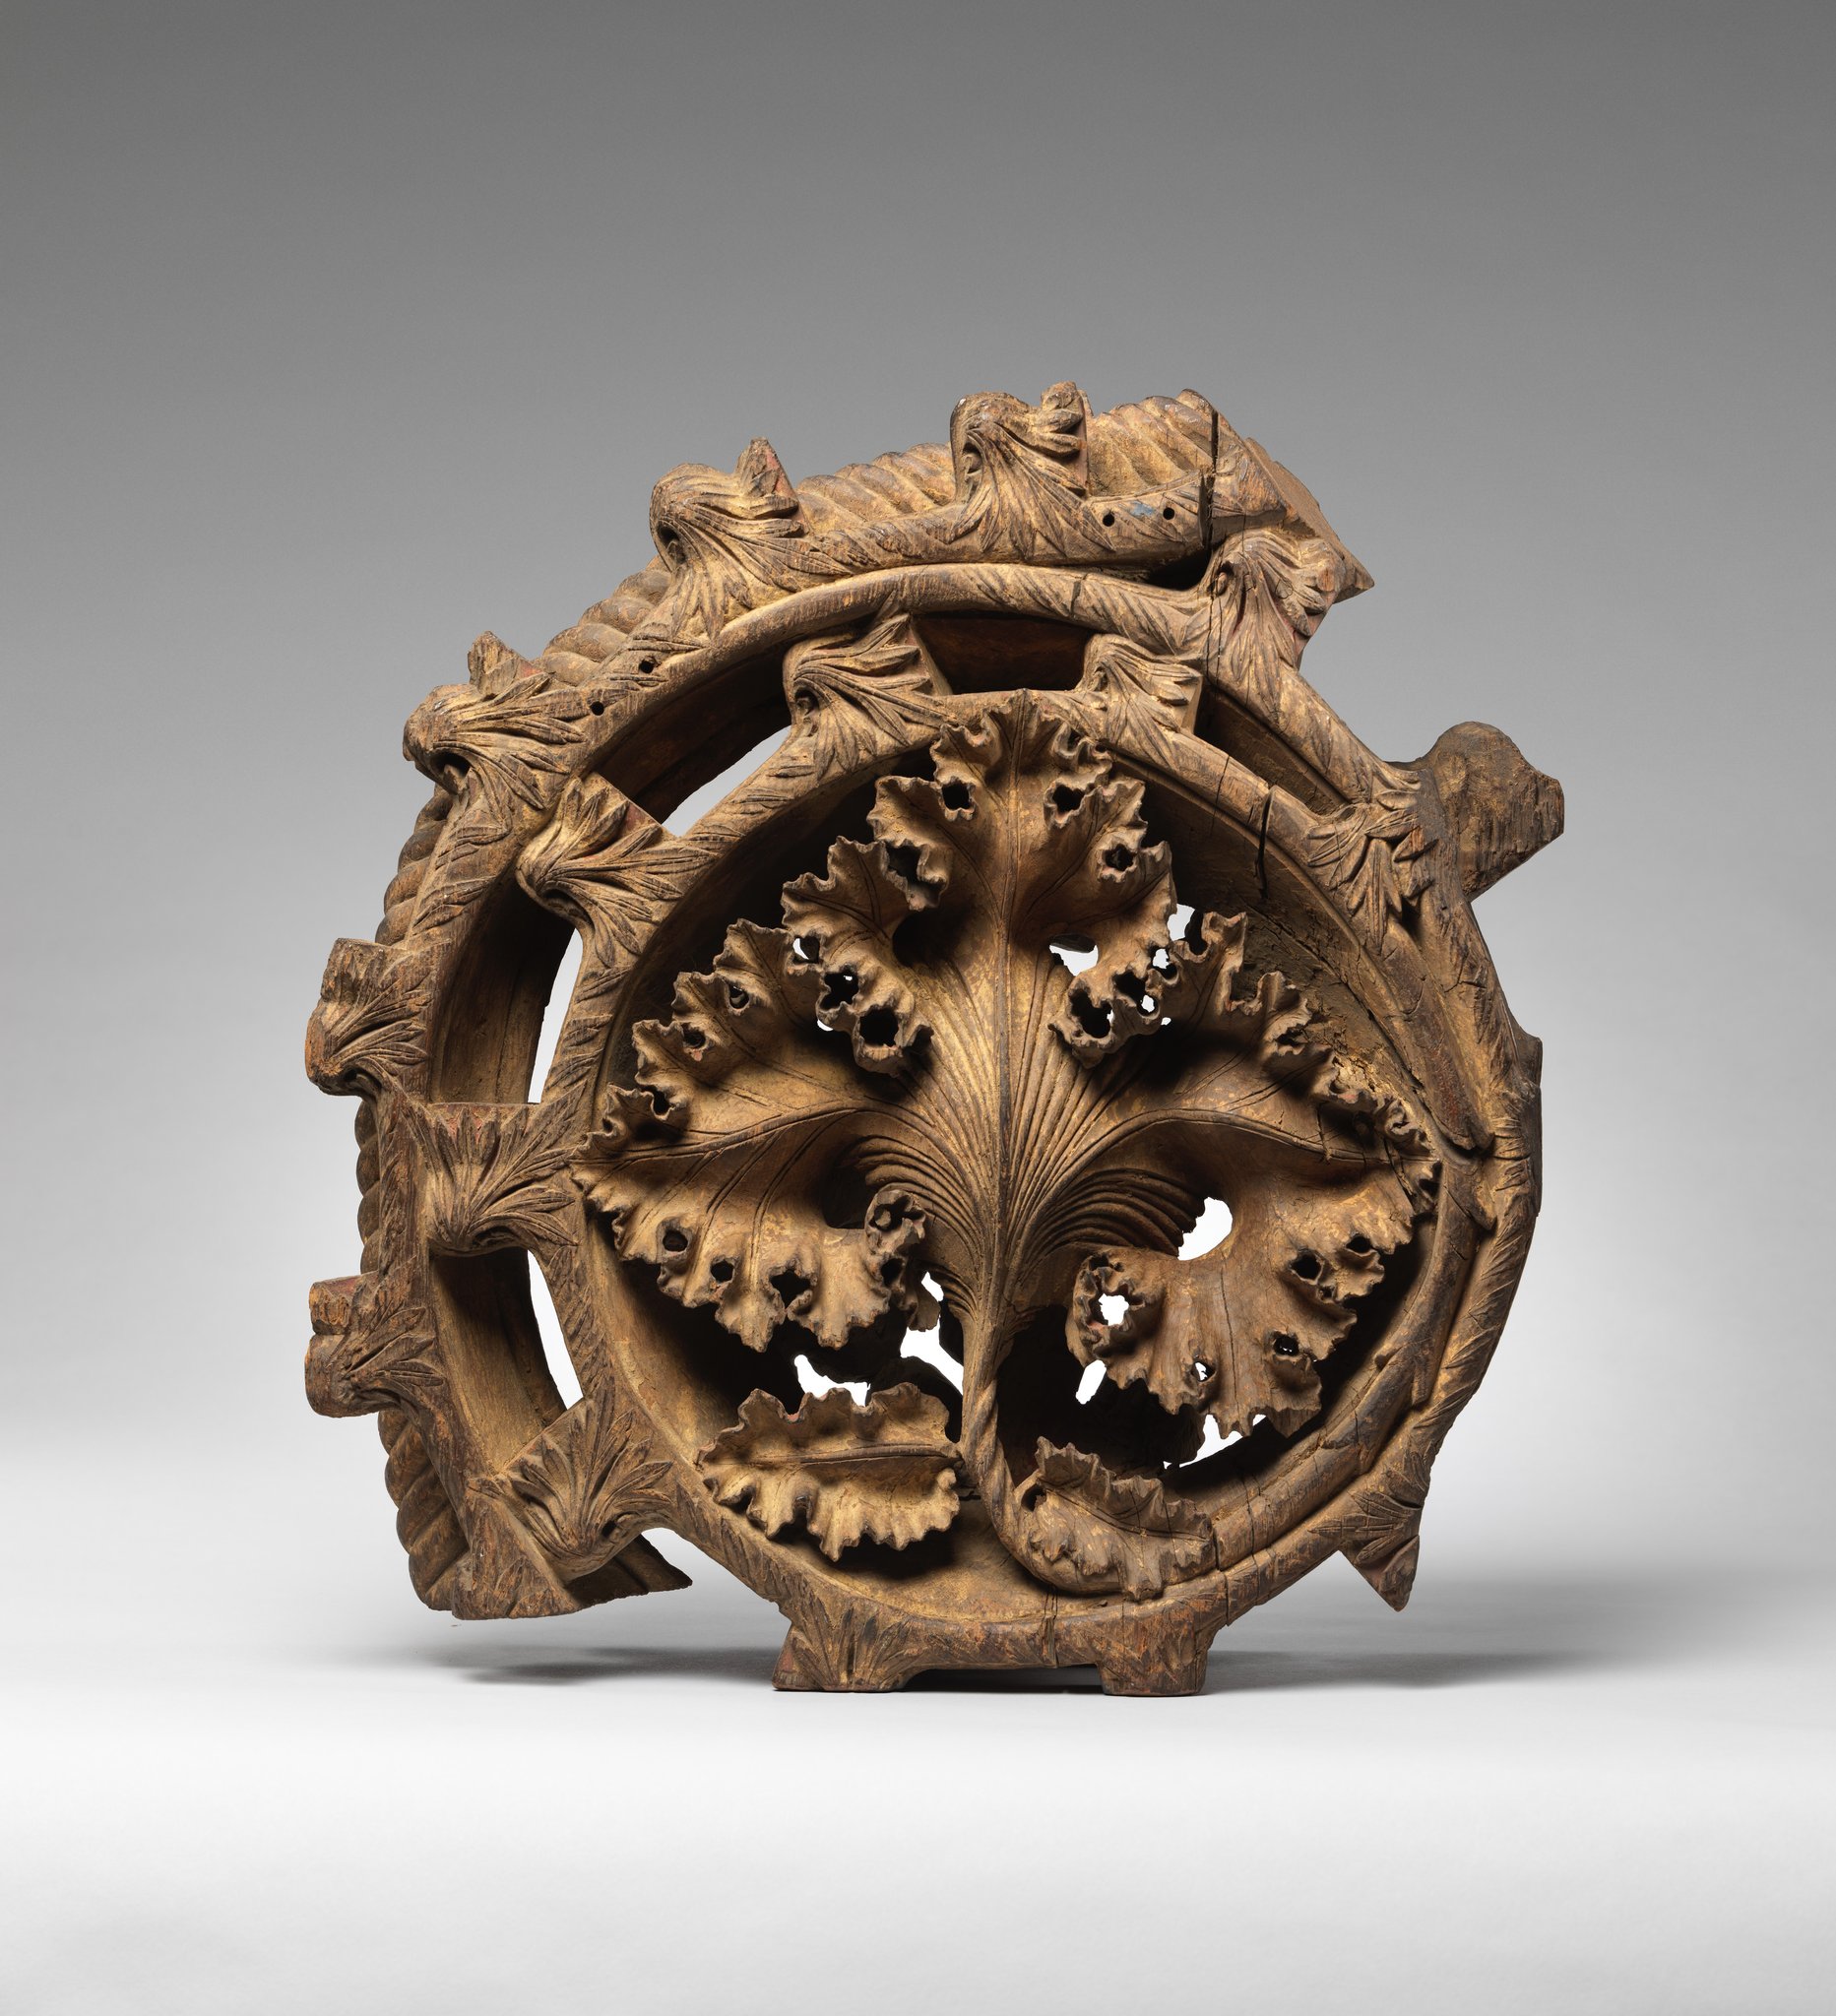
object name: bos or volute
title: Boss or Volute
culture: british or south netherlandish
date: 1467-1500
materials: wood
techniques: gilding, polychromy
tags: fruit